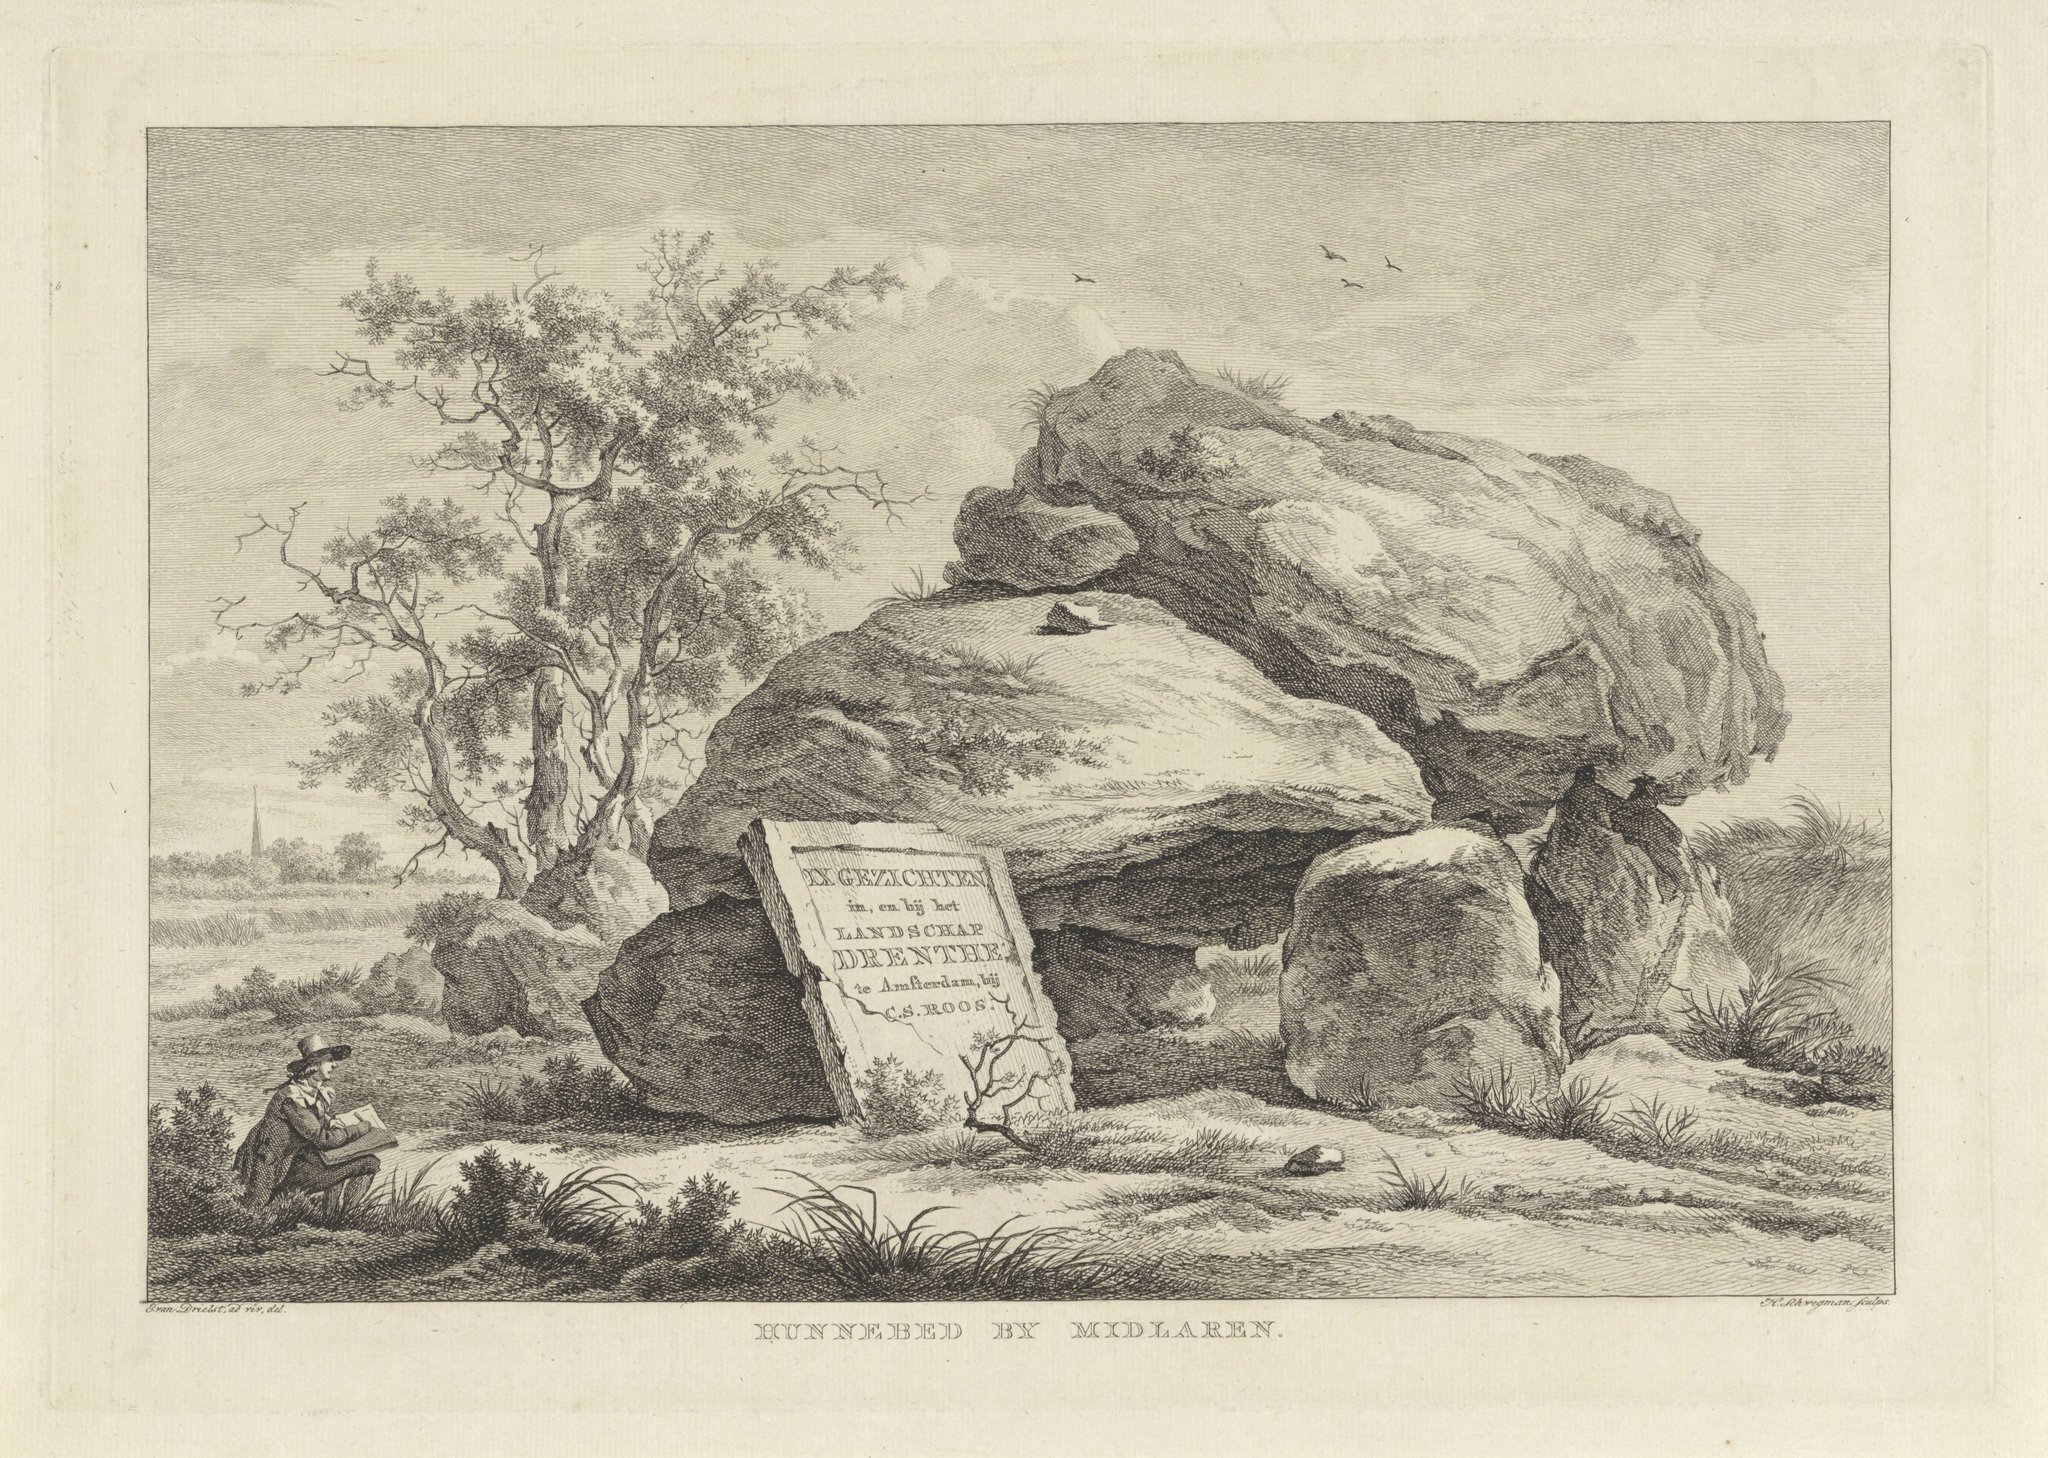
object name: print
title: IX Gezichten in en bij het landschap Drenthe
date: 1771-1816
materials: paper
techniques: etching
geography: midlaren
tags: megalithic chambered tomb, dolmen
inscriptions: collector's mark: Lugt 2228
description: Hunebed bij het dorp Midlaren in Drenthe. Links zit een tekenaar.